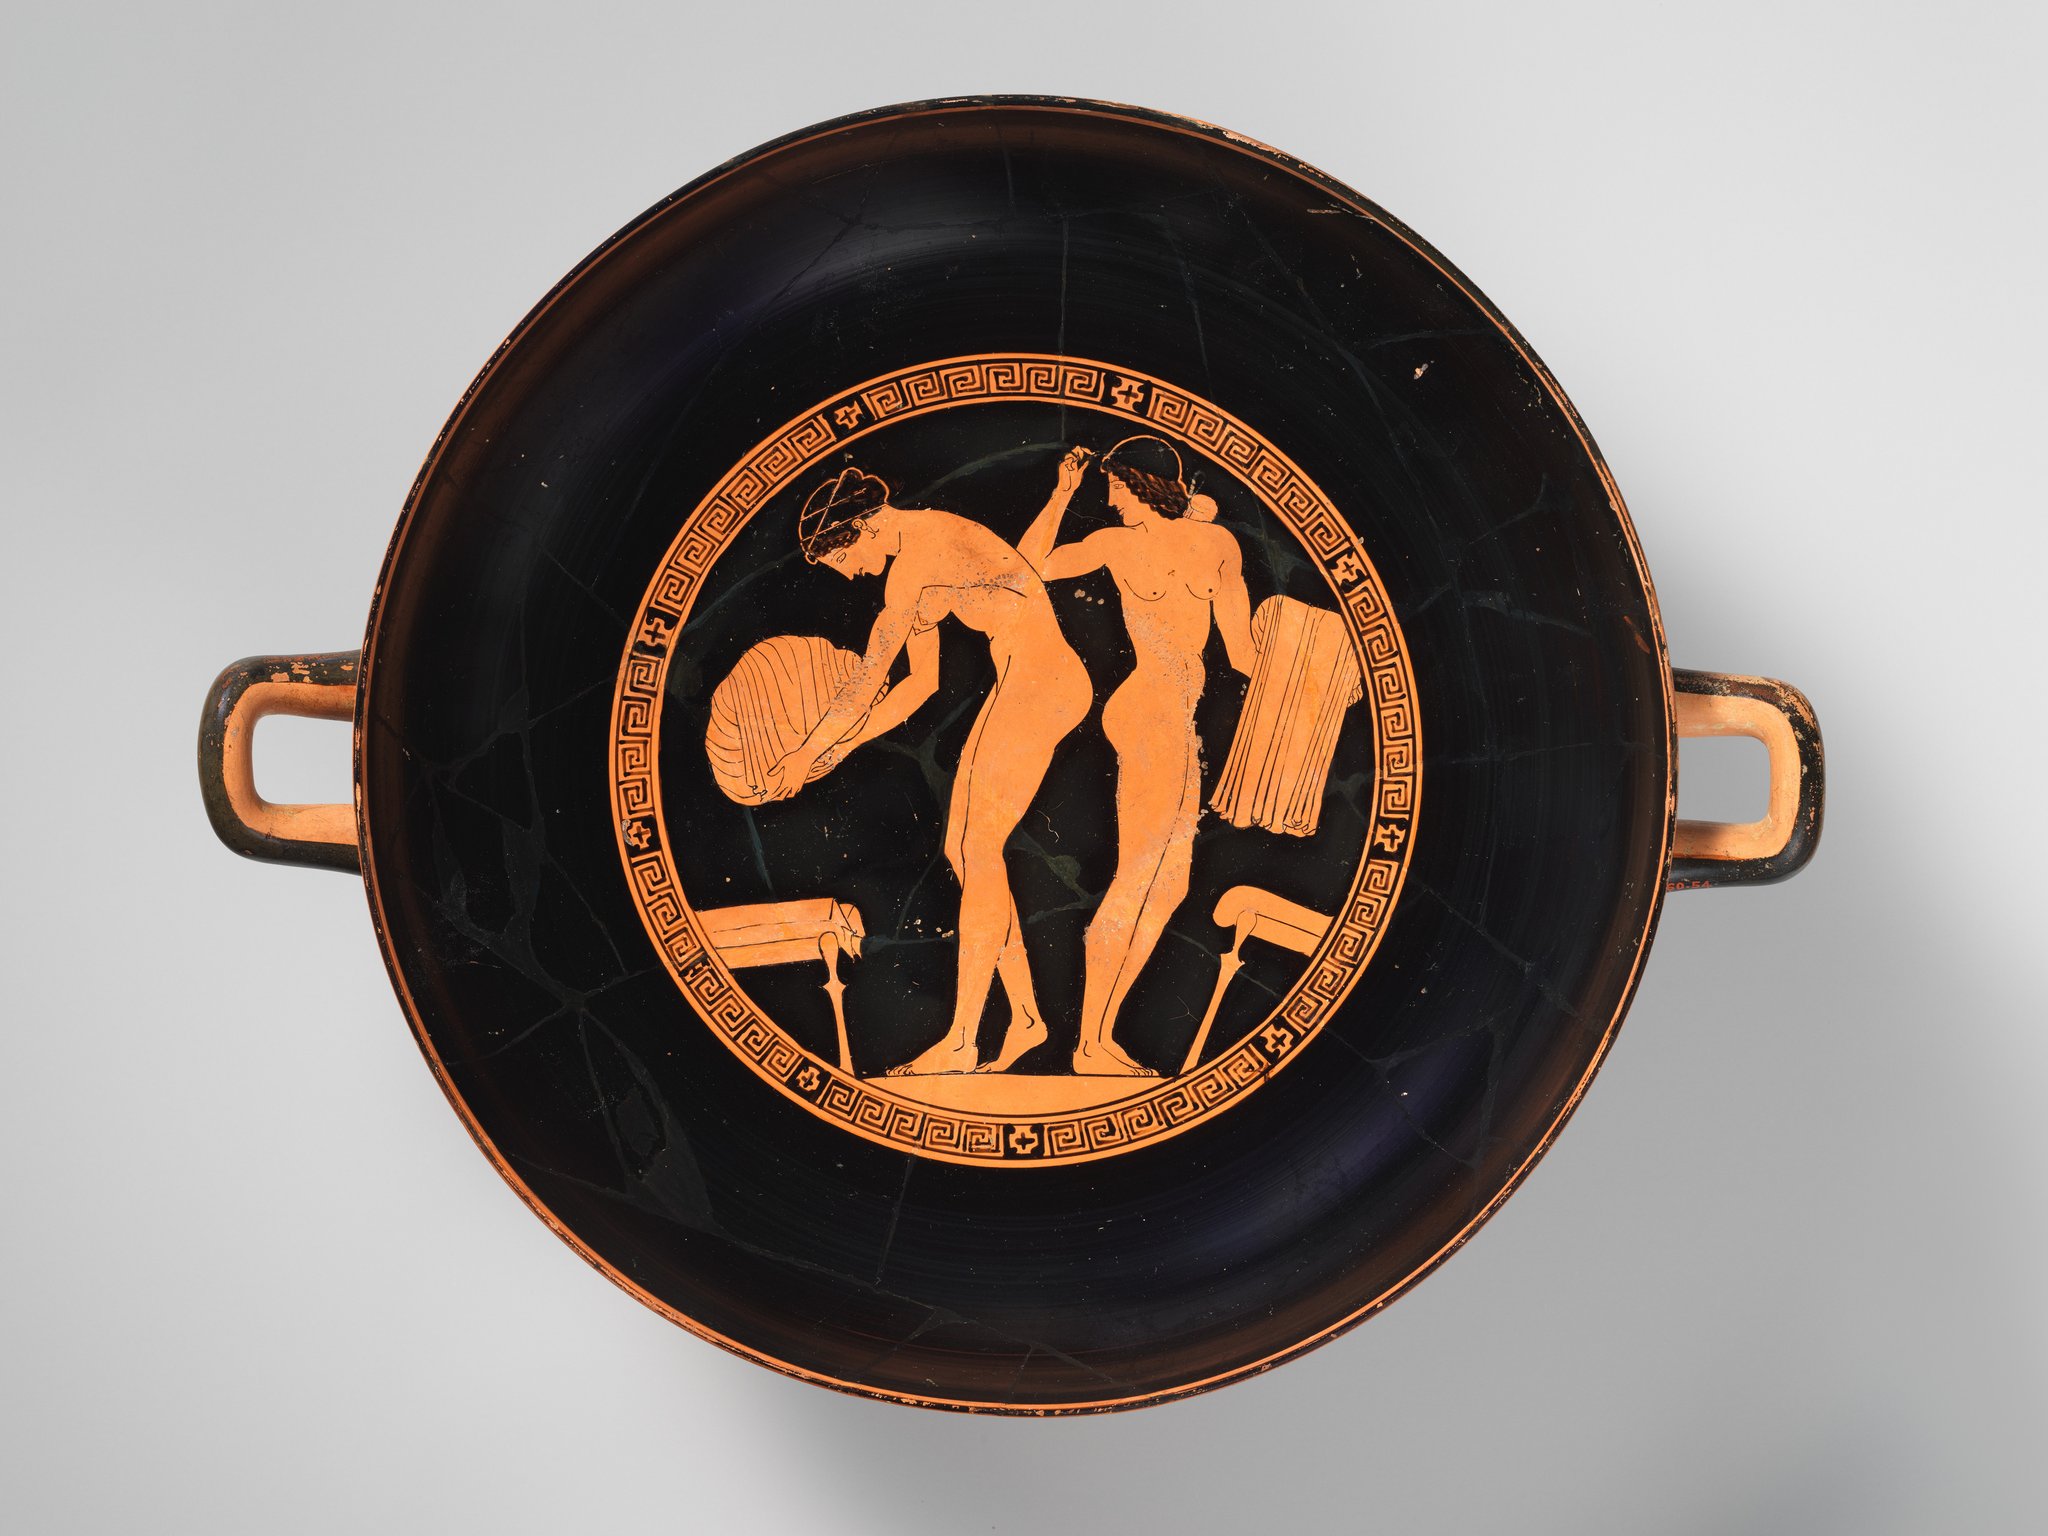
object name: kylix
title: Terracotta kylix (drinking cup)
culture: greek, attic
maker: douris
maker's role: artist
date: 470 BCE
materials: terracotta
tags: female nudes